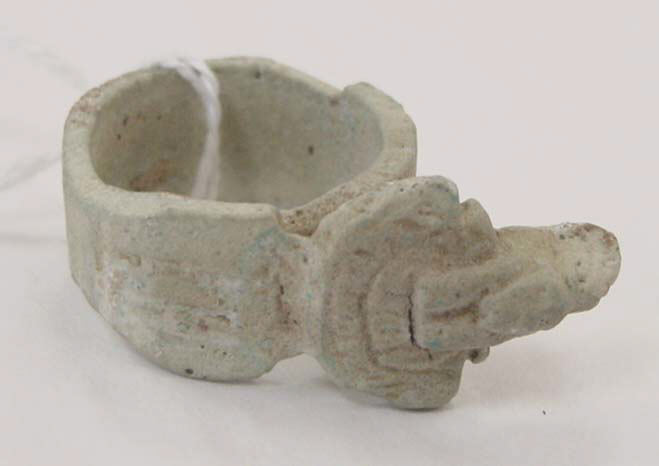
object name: ring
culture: egyptian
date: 1070-712 BCE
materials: faience